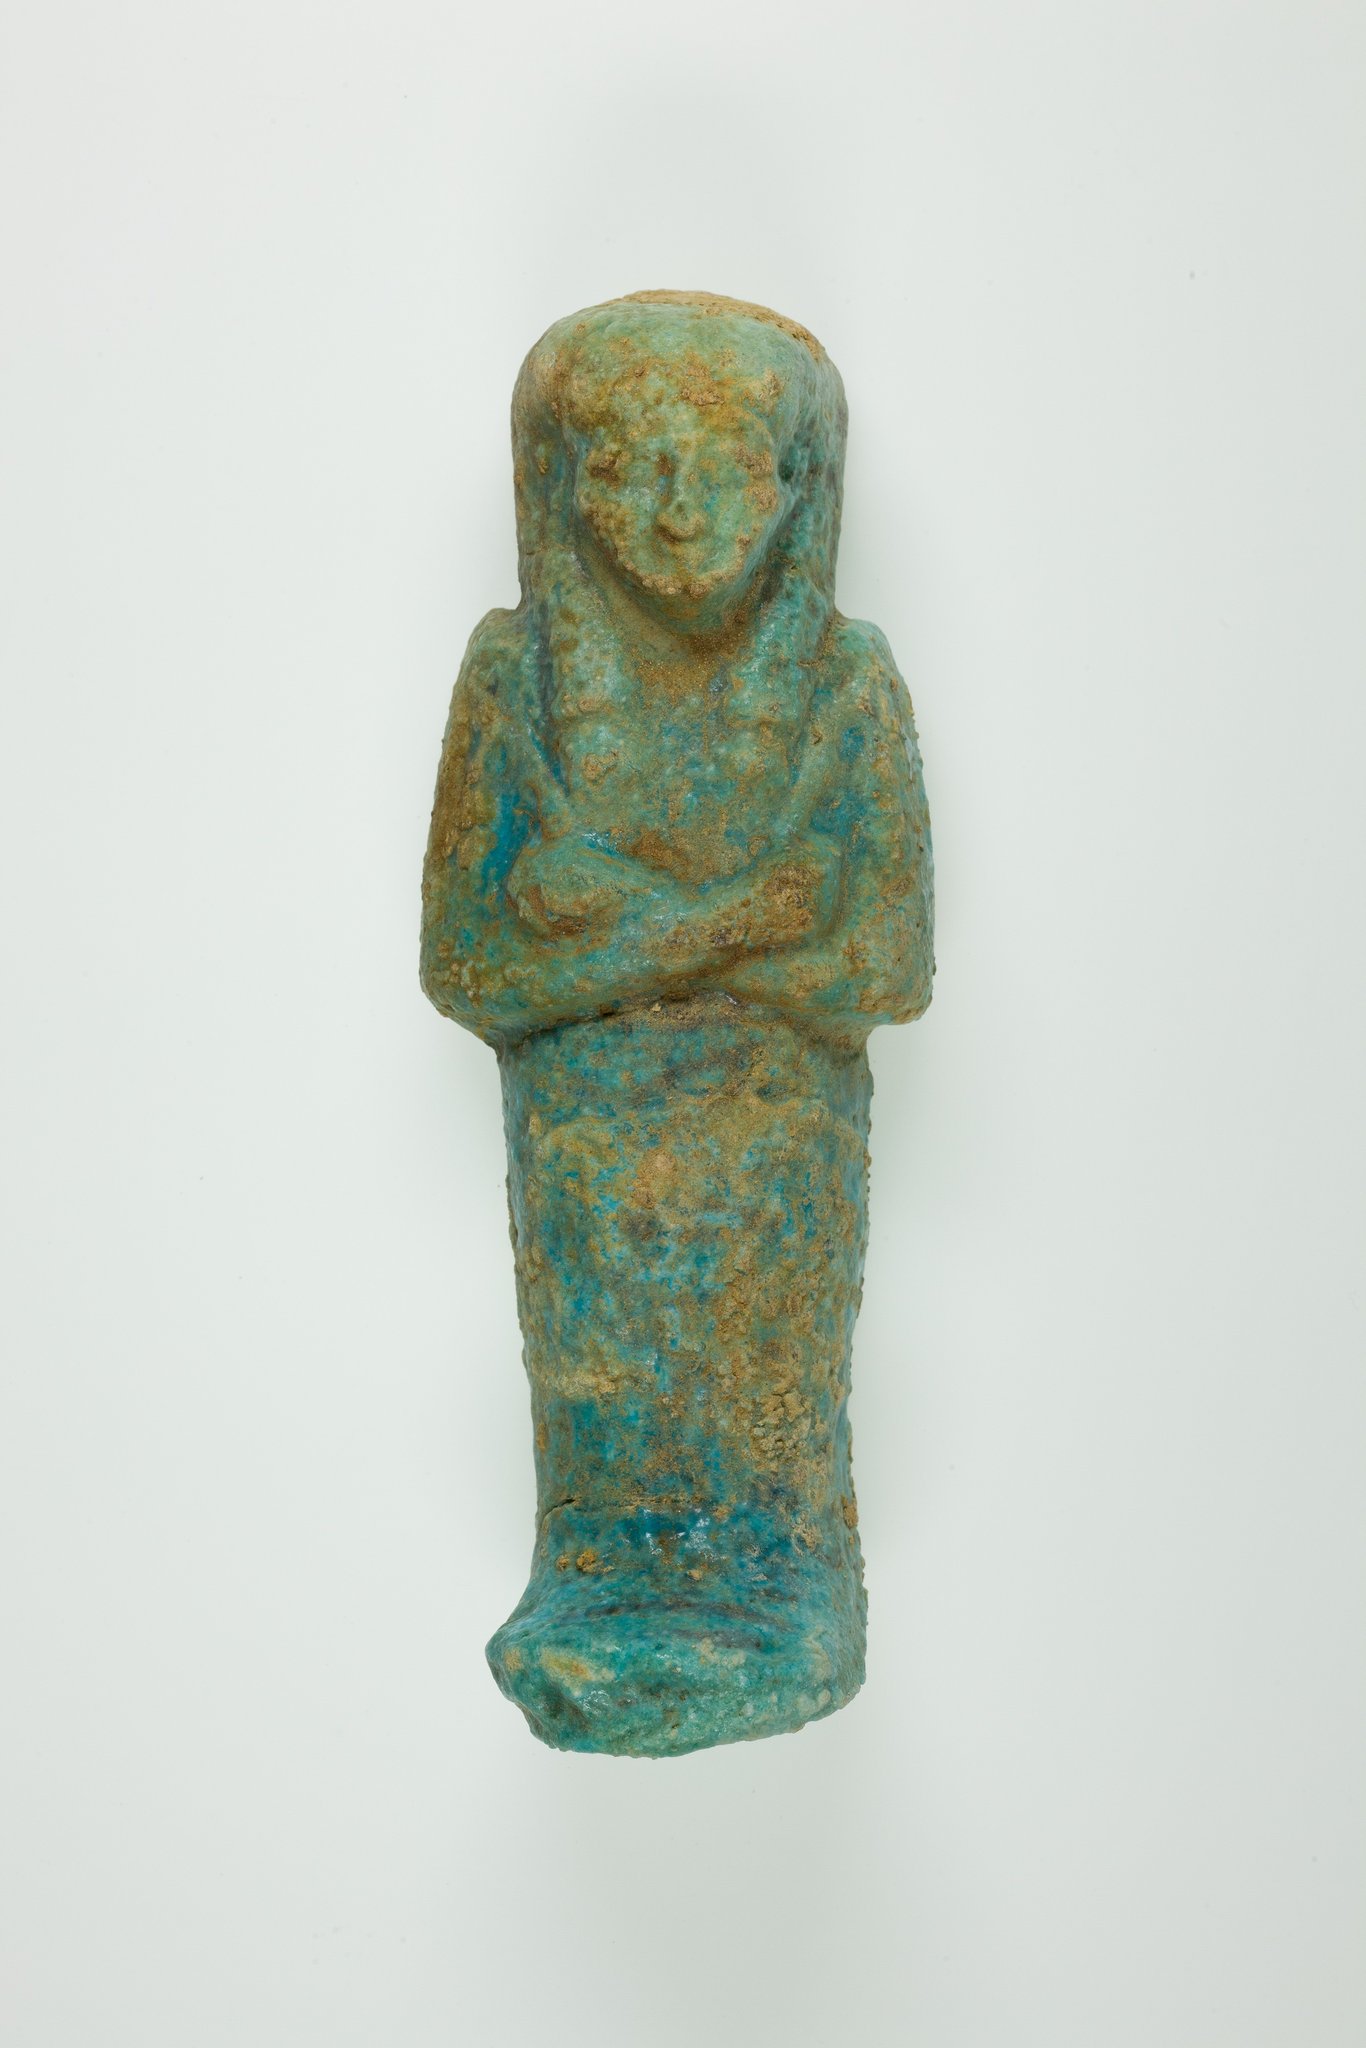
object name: shabti, henettawy c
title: Worker Shabti of Henettawy (C), Daughter of Isetemkheb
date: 990-970 BCE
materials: faience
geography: egypt